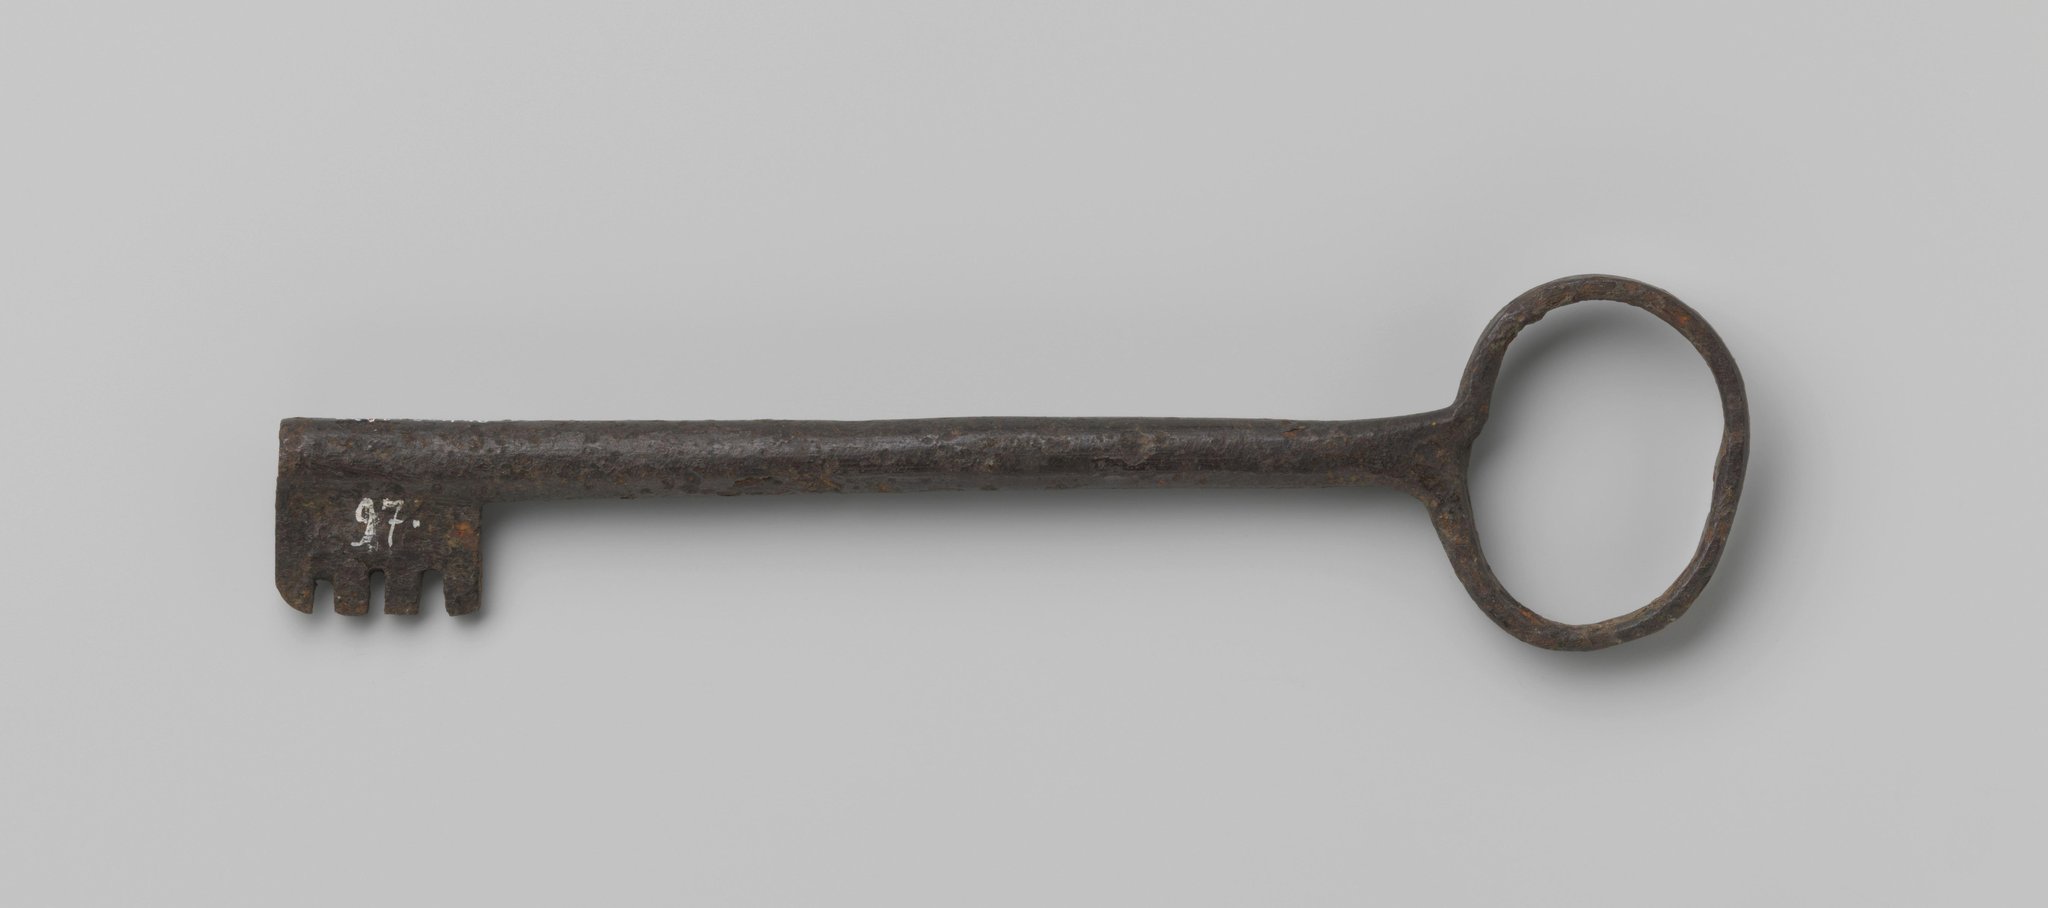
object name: pipe key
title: Pijpsleutel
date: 1400-1500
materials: iron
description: Pijpsleutel met lange schacht en ovaal oog. De kleine baard loopt uit in drie tanden.